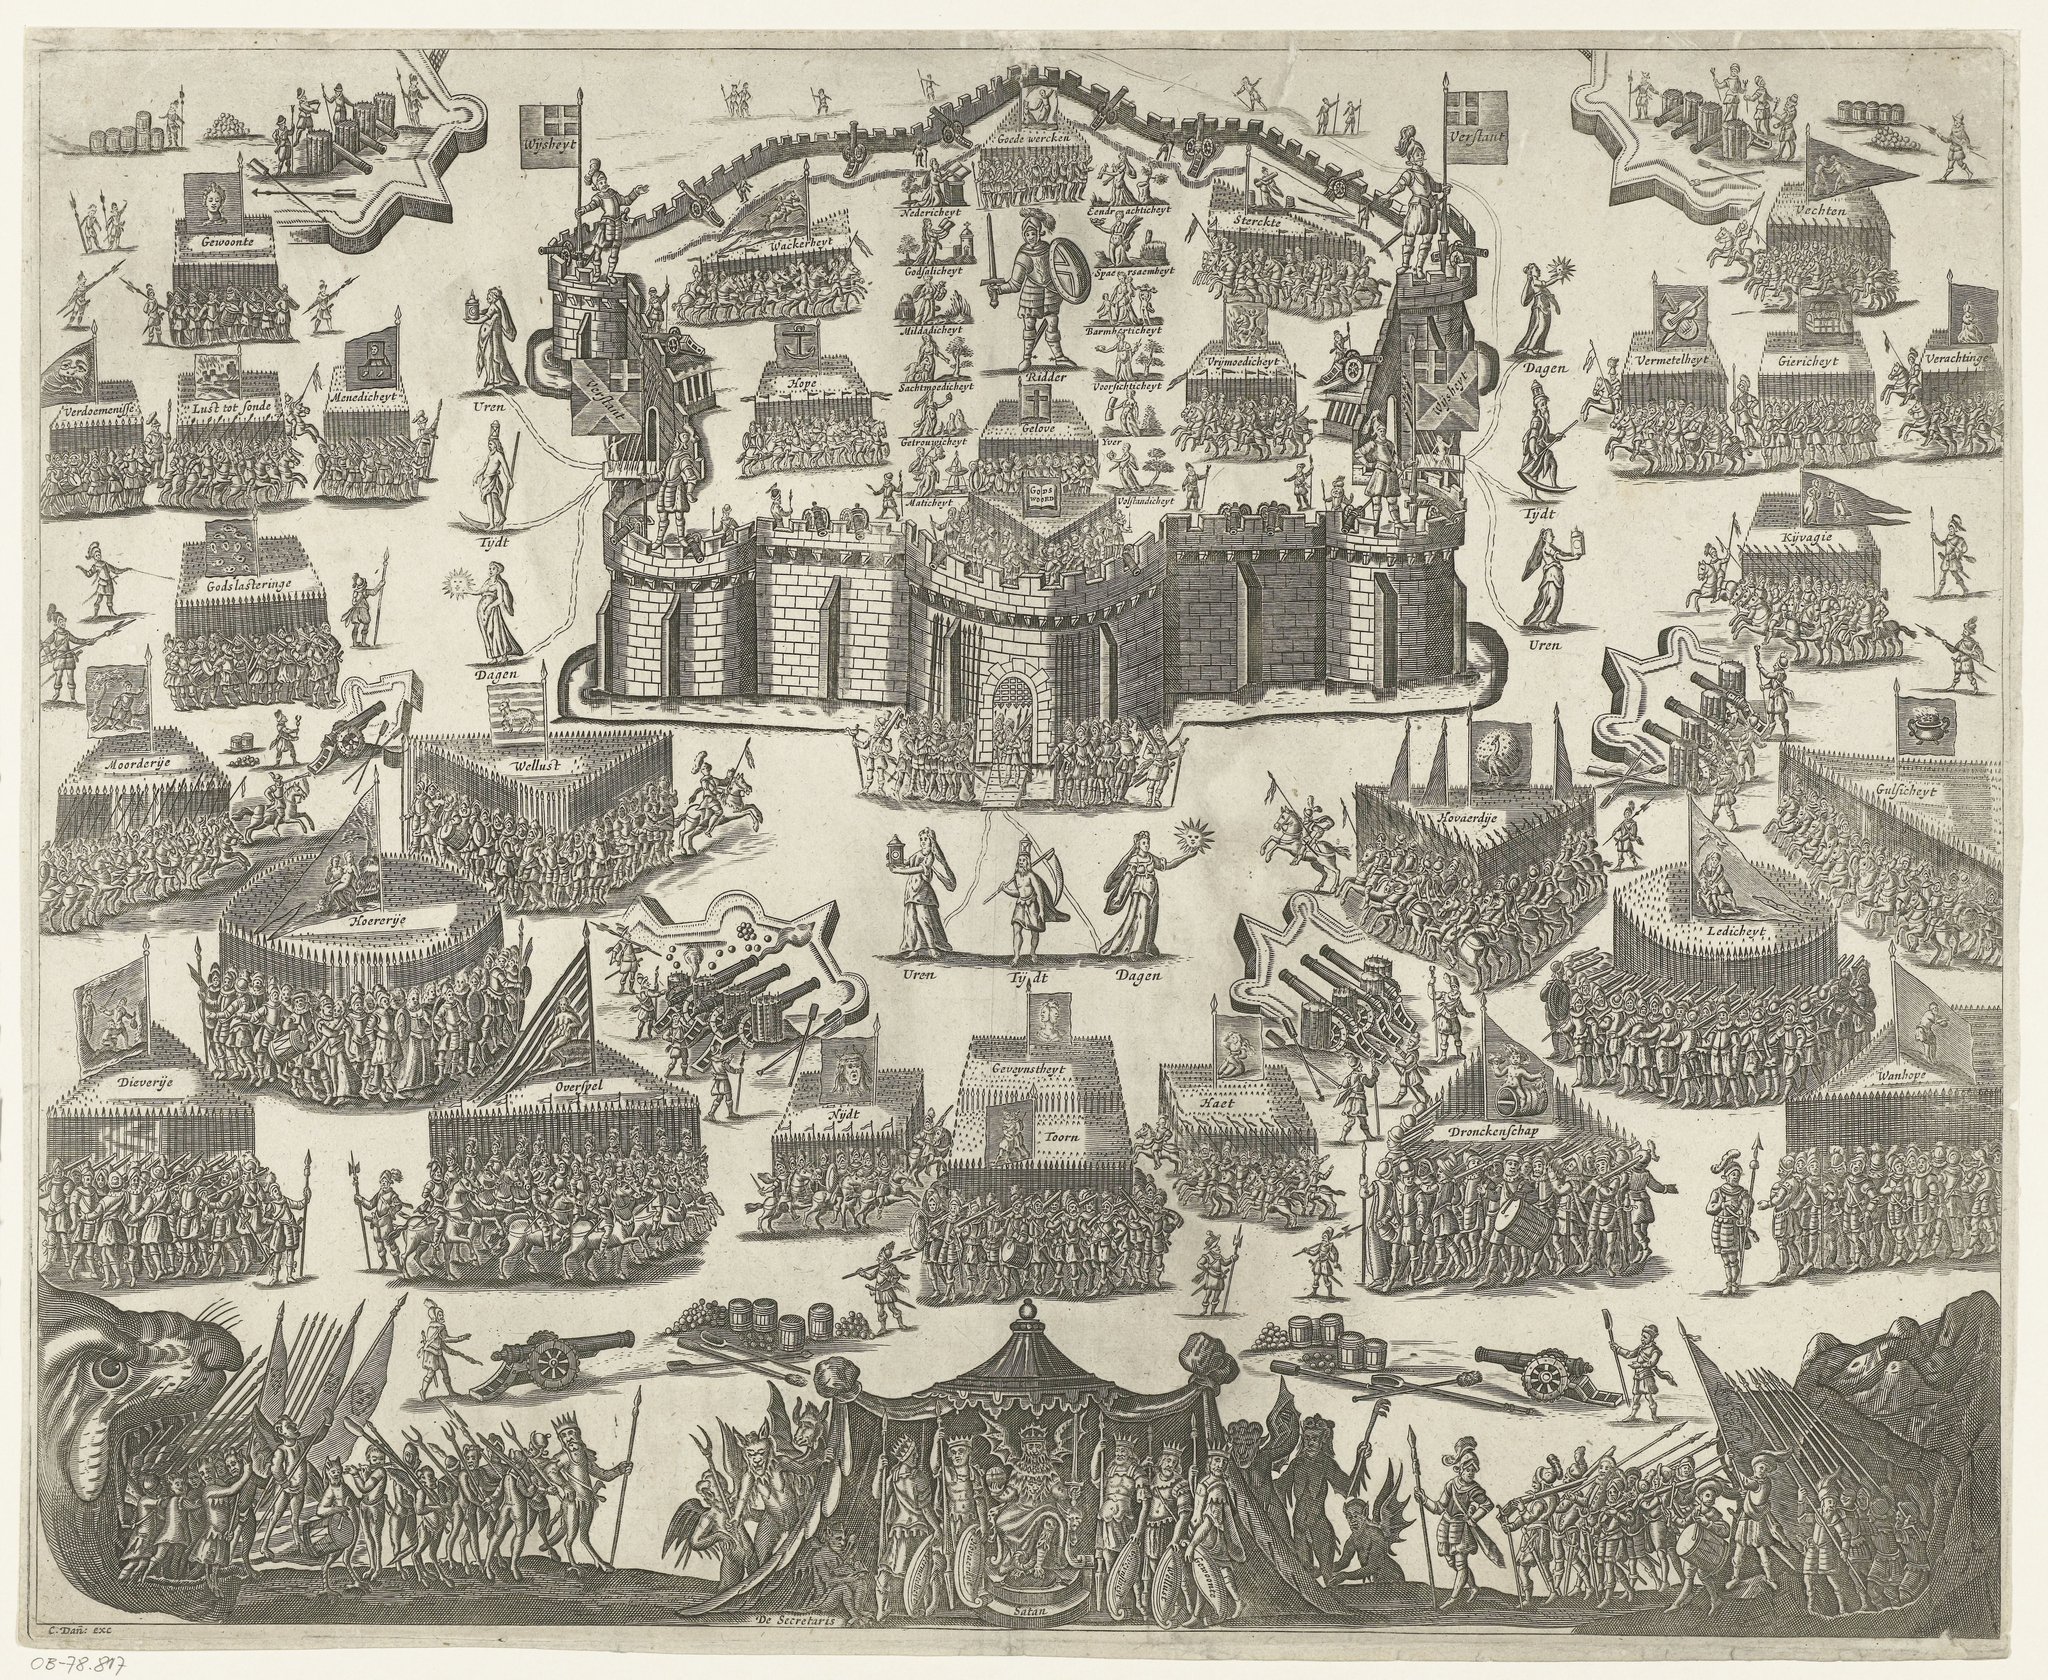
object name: print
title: Het strijdperk van de Christelijke Ridder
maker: Anonymous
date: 1630-1650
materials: paper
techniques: engraving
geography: low countries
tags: reformation (roman catholic church vs. protestantism), the christian knight, 'miles christianus'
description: Het strijdperk van de Christelijke Ridder. De ridder staat in het midden van zijn vesting en wordt bijgestaan door legers onder banieren van deugdzame idealen. Het kasteel is omringd en wordt belegerd door de troepen van de duivel die op de voorgrond zijn tent heeft opgeslagen. Deze legers strijden onder de vlag van allerlei zonden en ondeugden. Op de voorgrond komen van links en rechts nieuwe soldaten uit de mond van de hel. Zinneprent op de Hervorming, thematiek van ca. 1560.